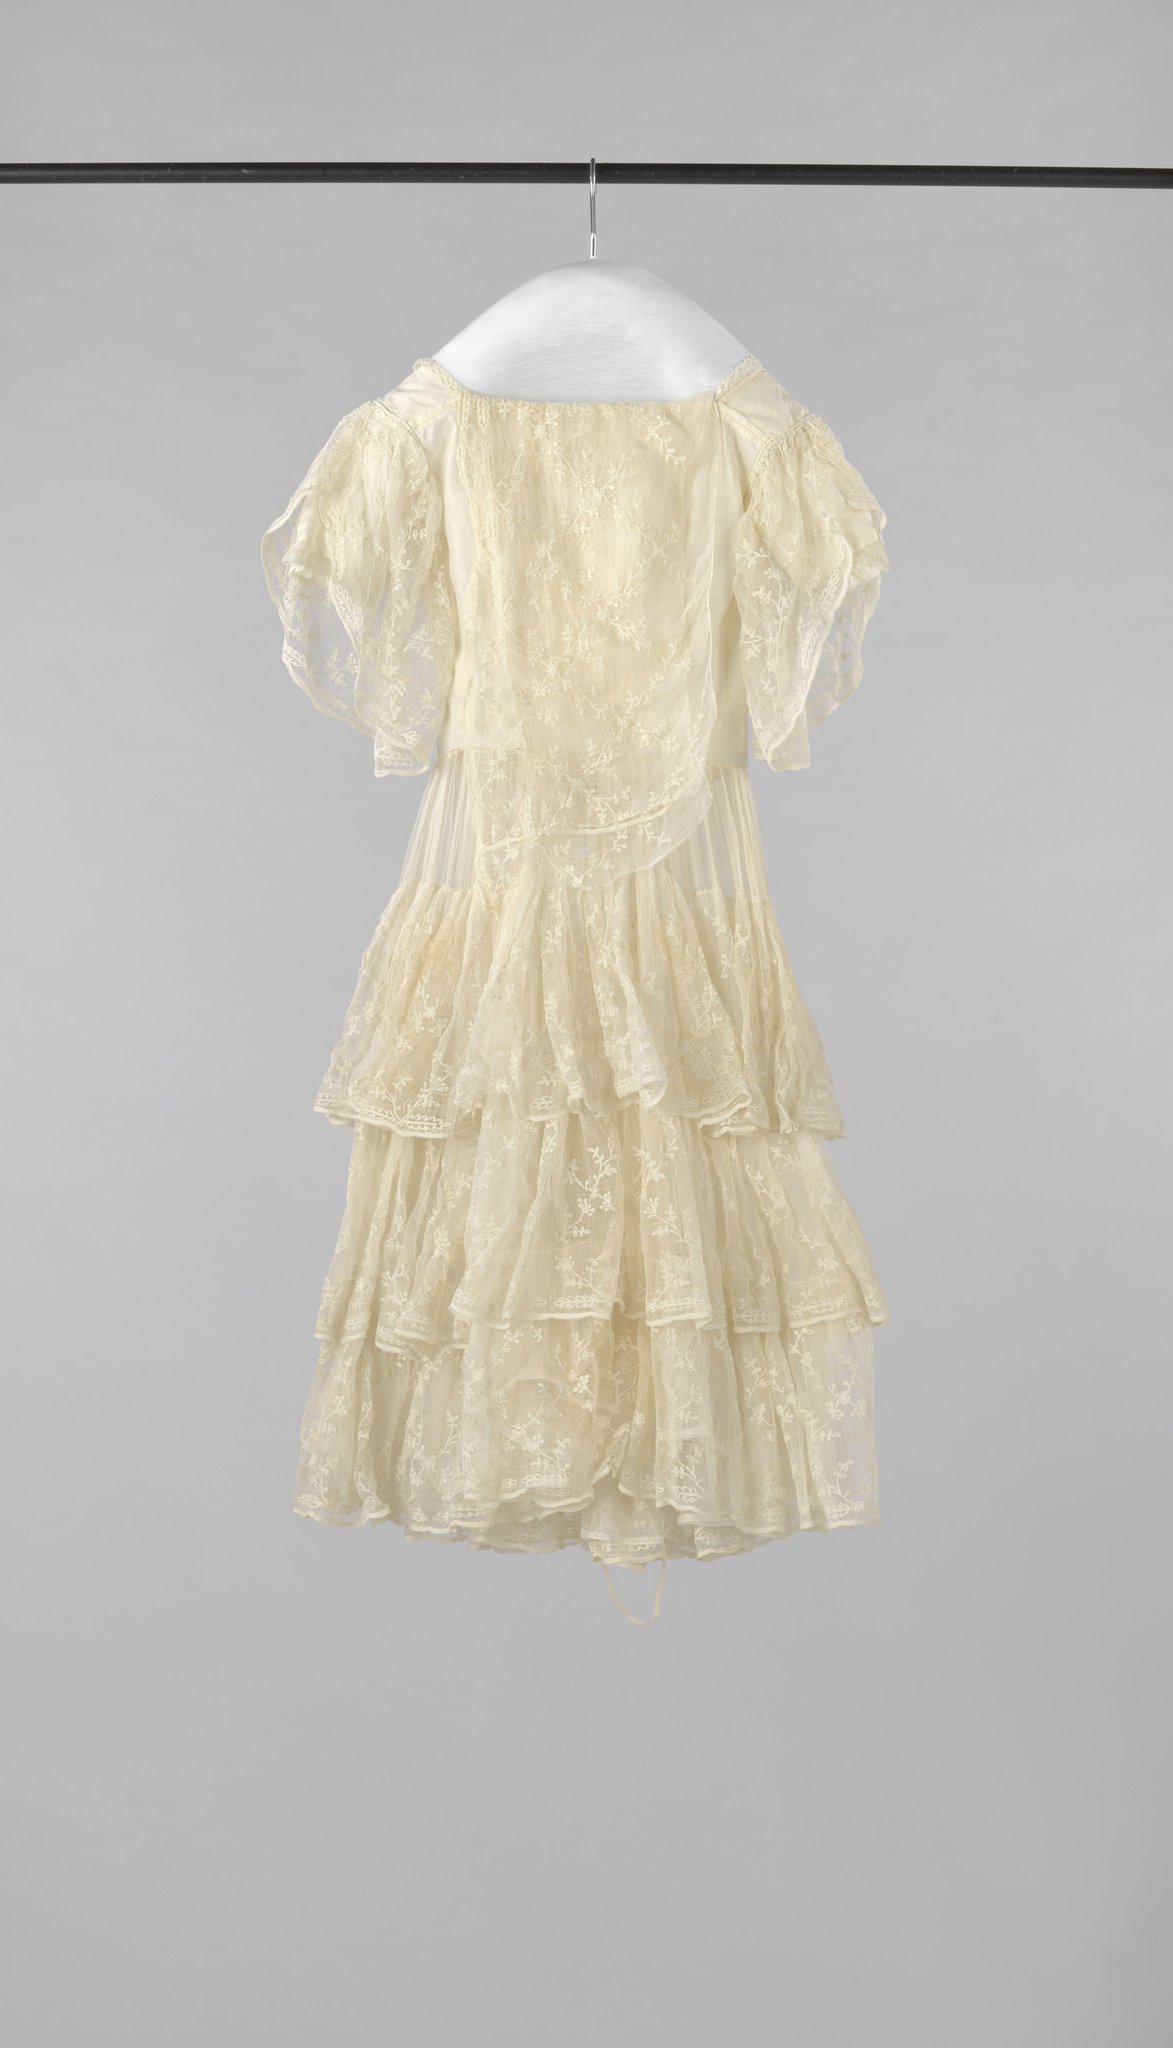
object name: main garment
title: Kinderjurk van wit tarlatan met vierkante hals en korte mouwen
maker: Anonymous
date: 1850-1900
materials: textile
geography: netherlands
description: Een kinderjurk van wit tarlatan. Het witgevoerd lijfje, dat door middel van een band van de rok is genaaid, heeft een vierkant uitgesneden hals en korte mouwen.